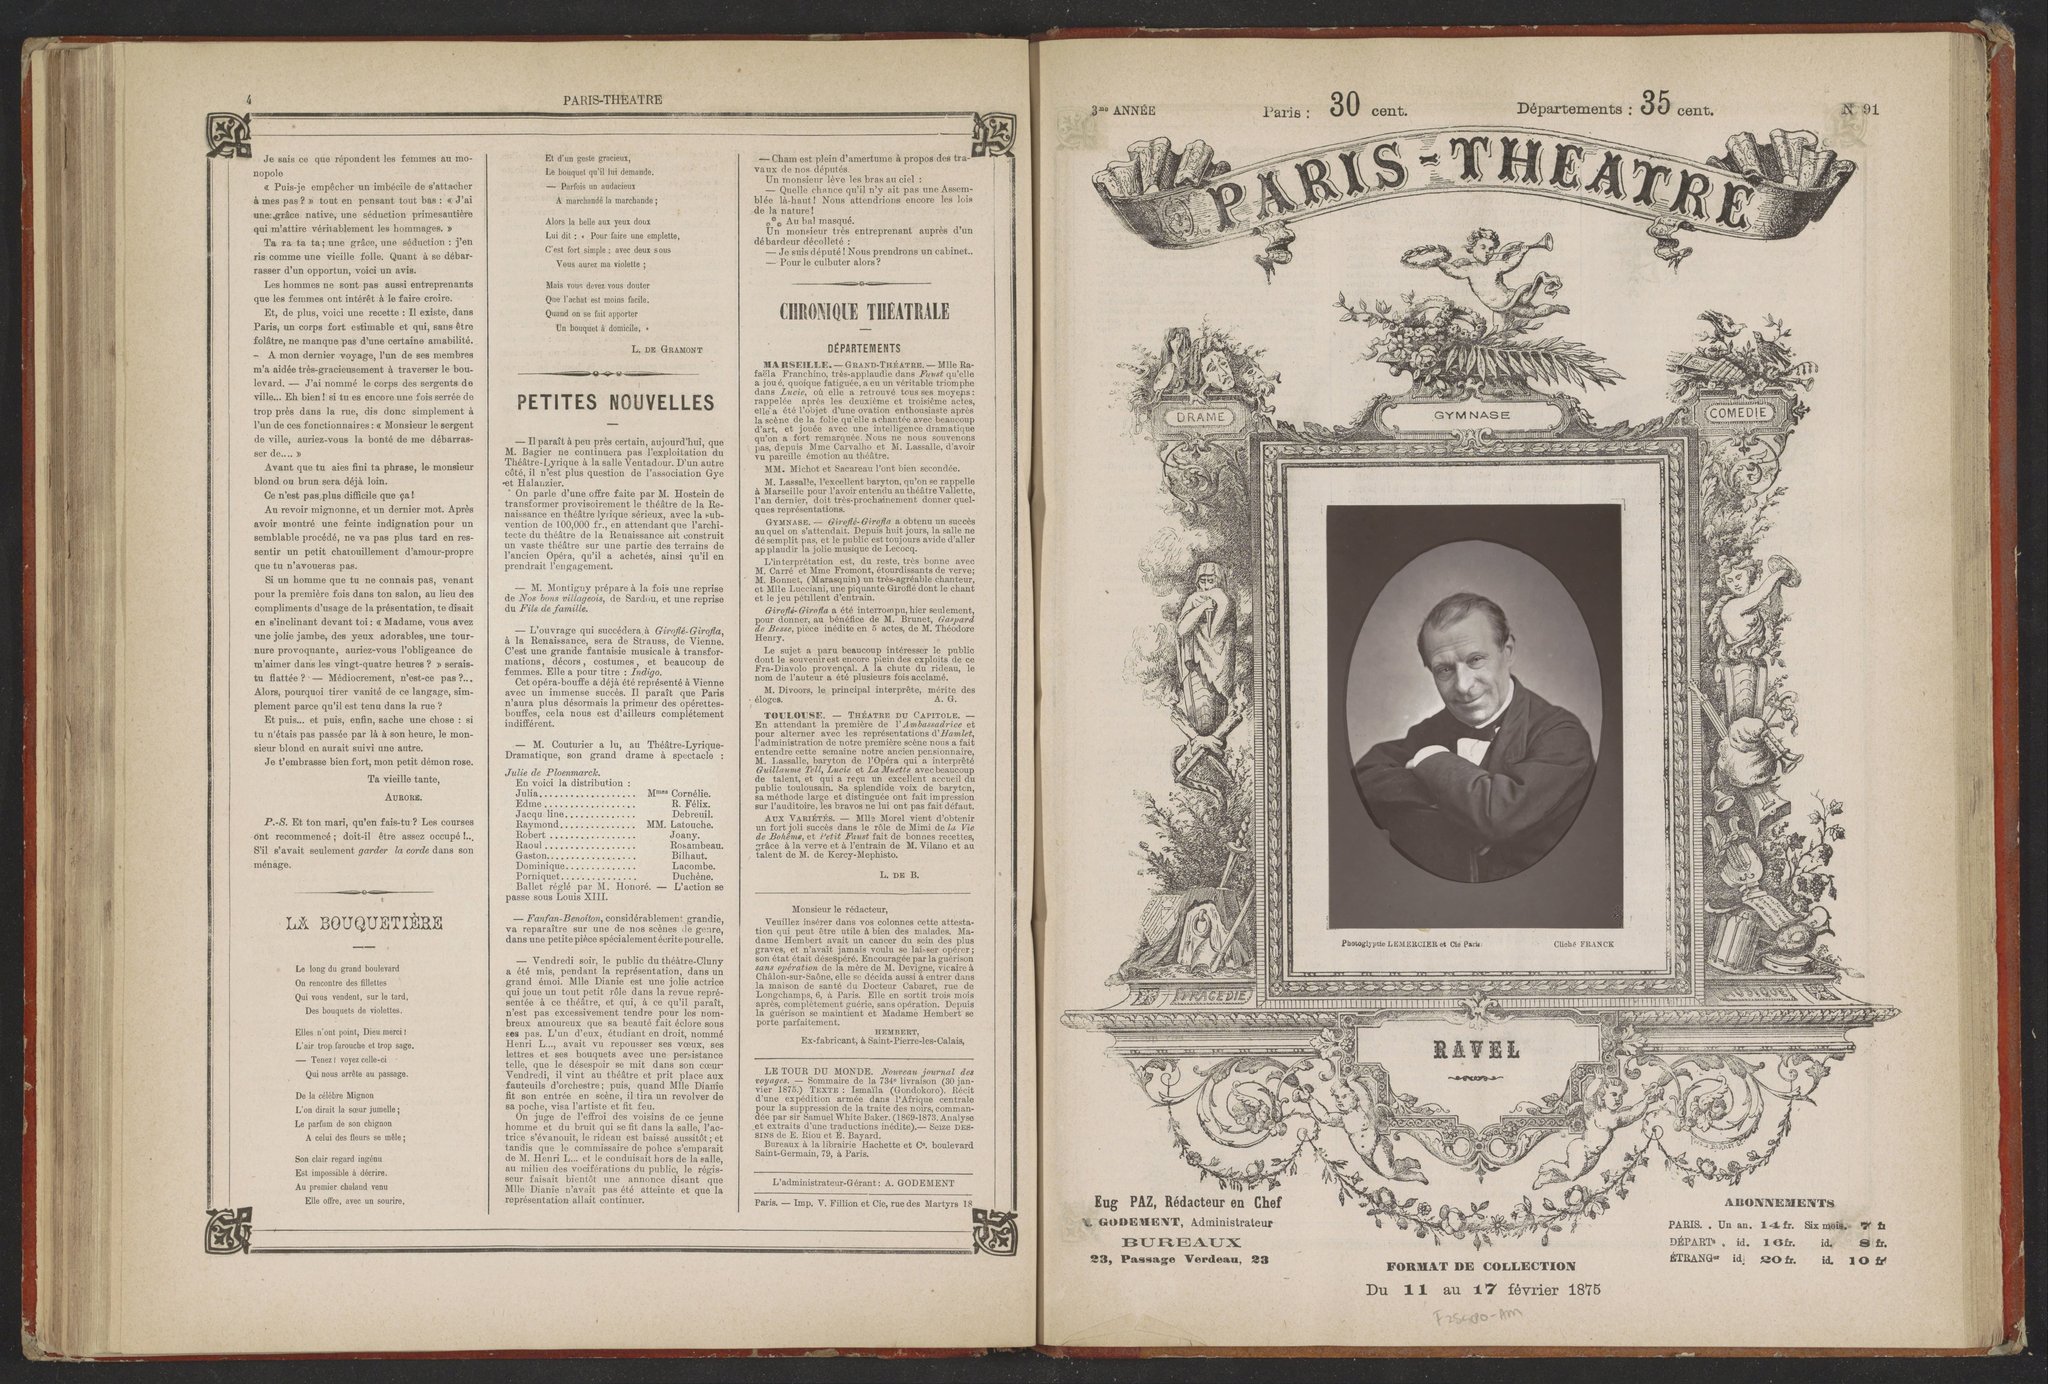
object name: page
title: Ravel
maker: françois marie louis franck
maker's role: fotograaf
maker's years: 1816-1906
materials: paper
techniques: woodburytype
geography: france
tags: portrait of actor, actress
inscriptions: number: ‘No 91’, inscription: ‘Du 11 au 17 février 1875’